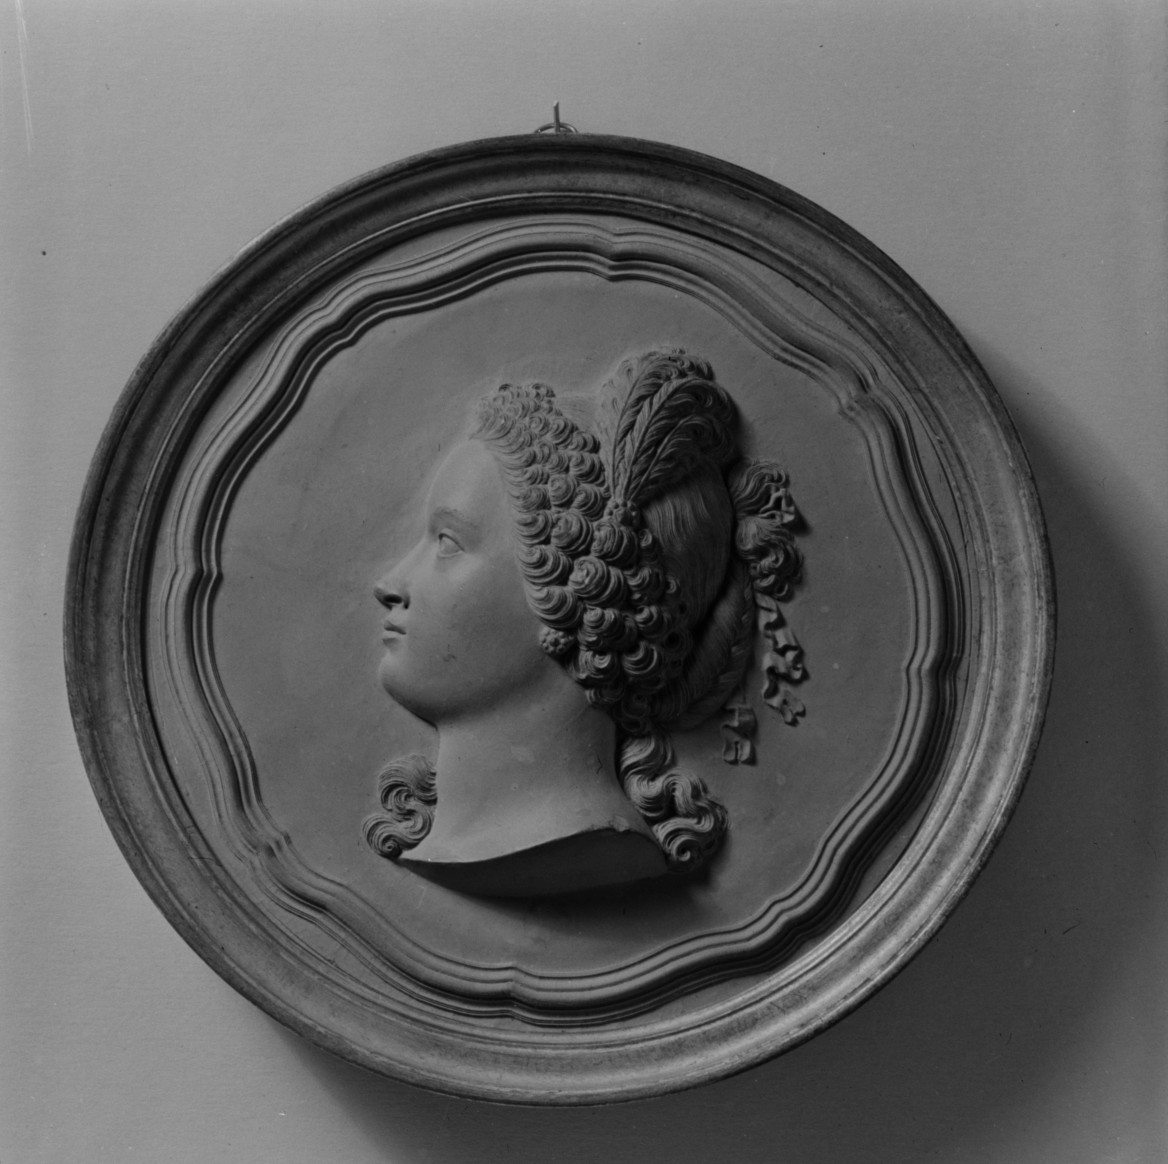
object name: medallion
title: Portrait of a lady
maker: jean-baptiste nini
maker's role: artist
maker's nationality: italian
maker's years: 1717-1786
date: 1701-1800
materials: gilt, terracotta, wood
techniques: casting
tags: profiles,women